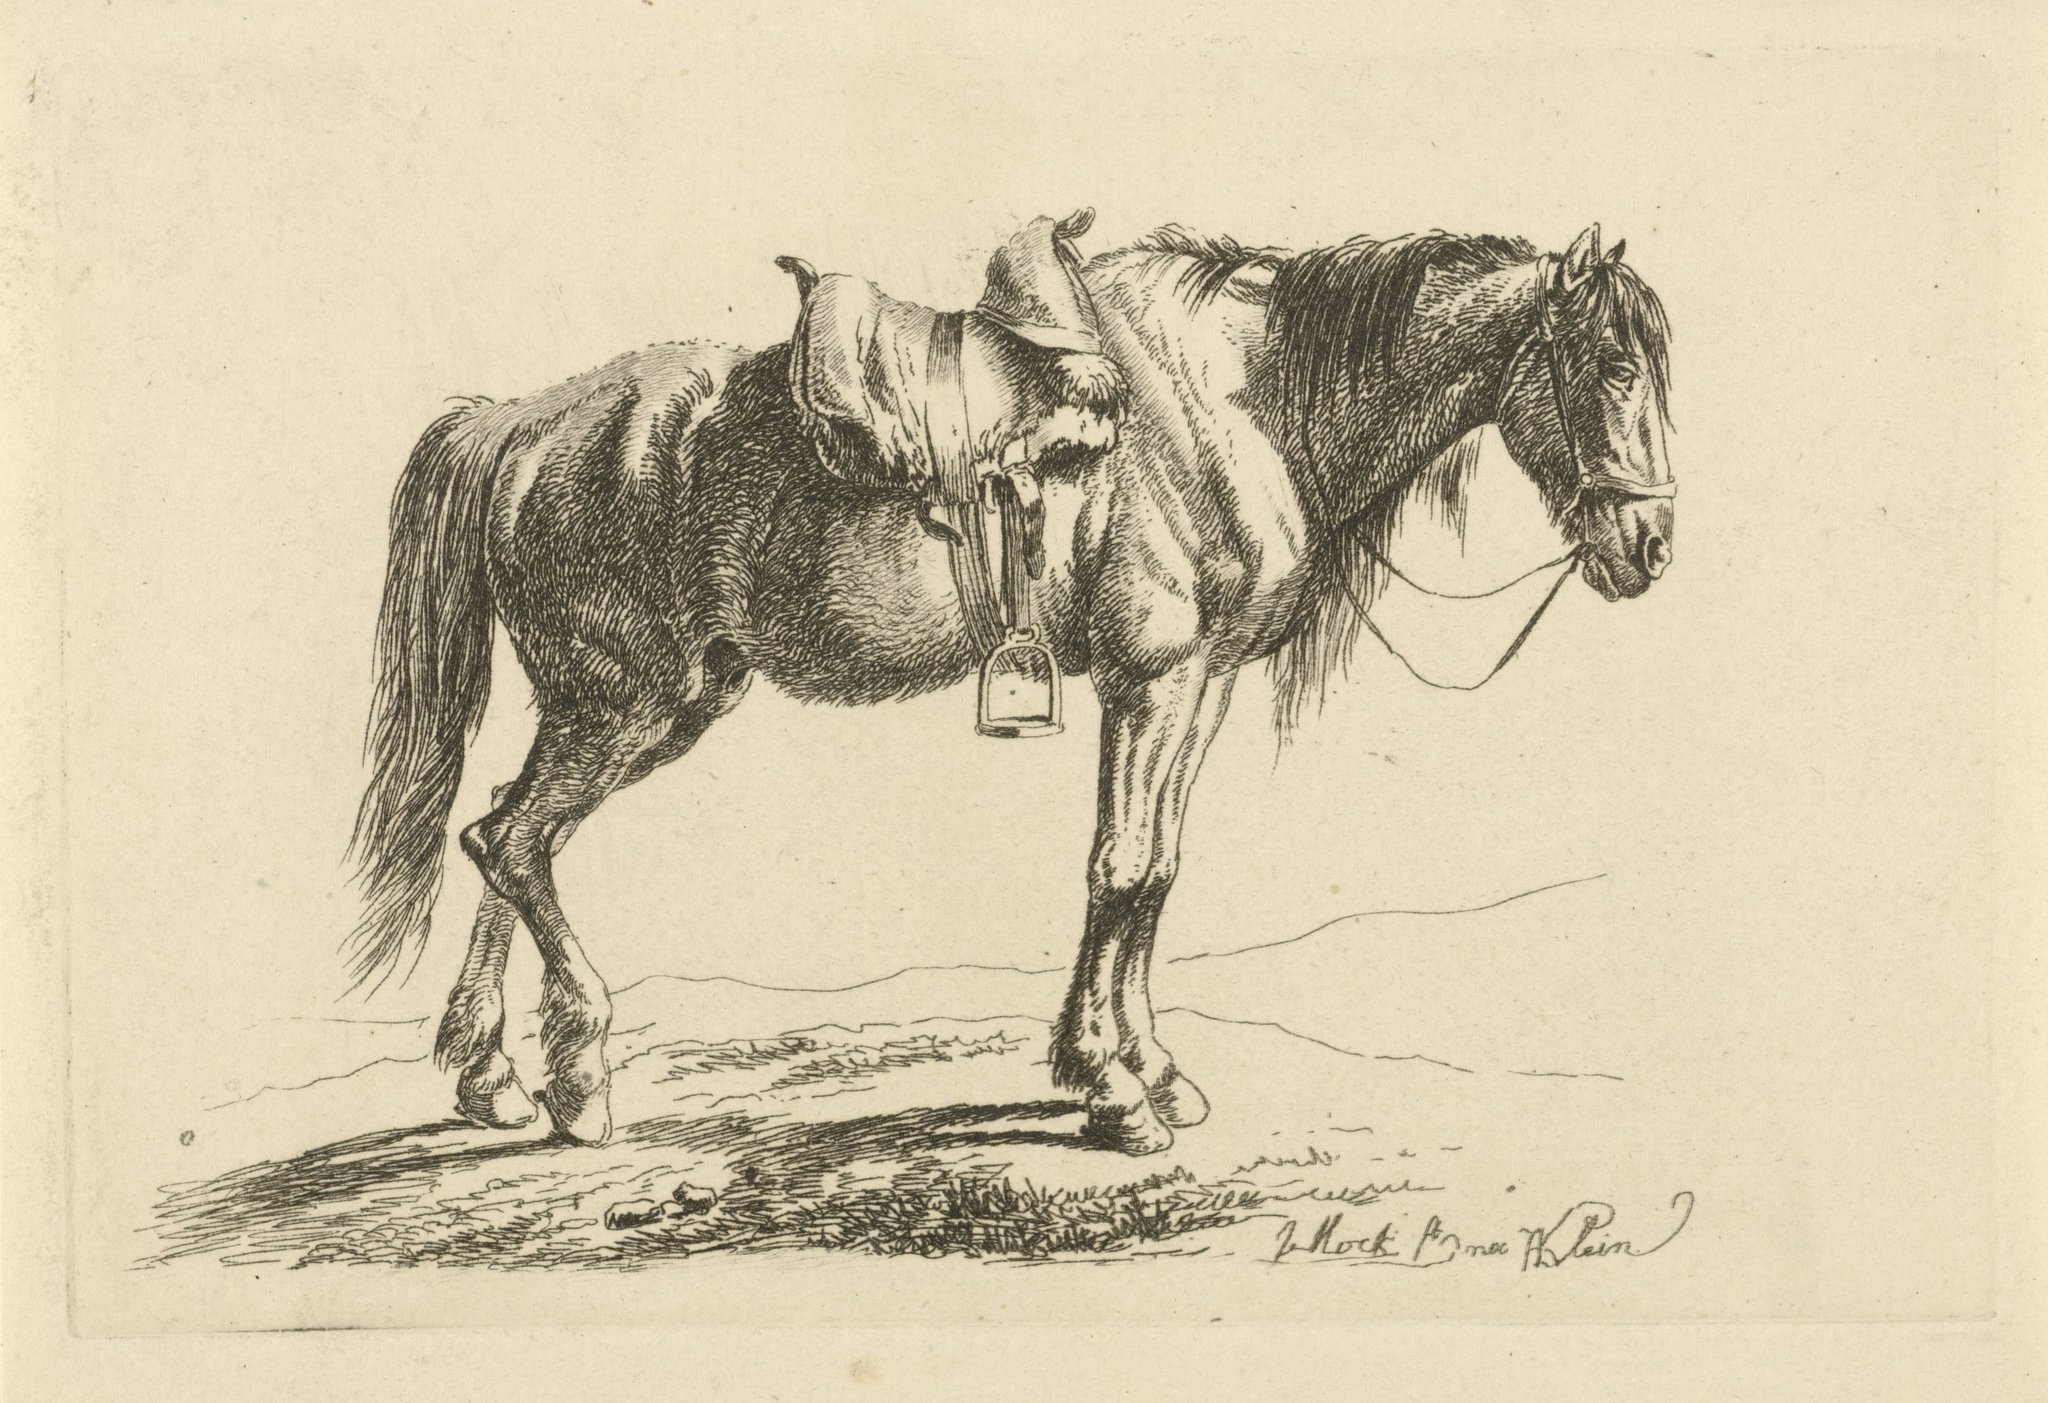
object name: print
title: Gezadeld paard naar rechts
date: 1810-1884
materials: paper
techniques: etching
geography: netherlands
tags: horses and kindred animals, saddle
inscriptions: collector's mark: Lugt 2228